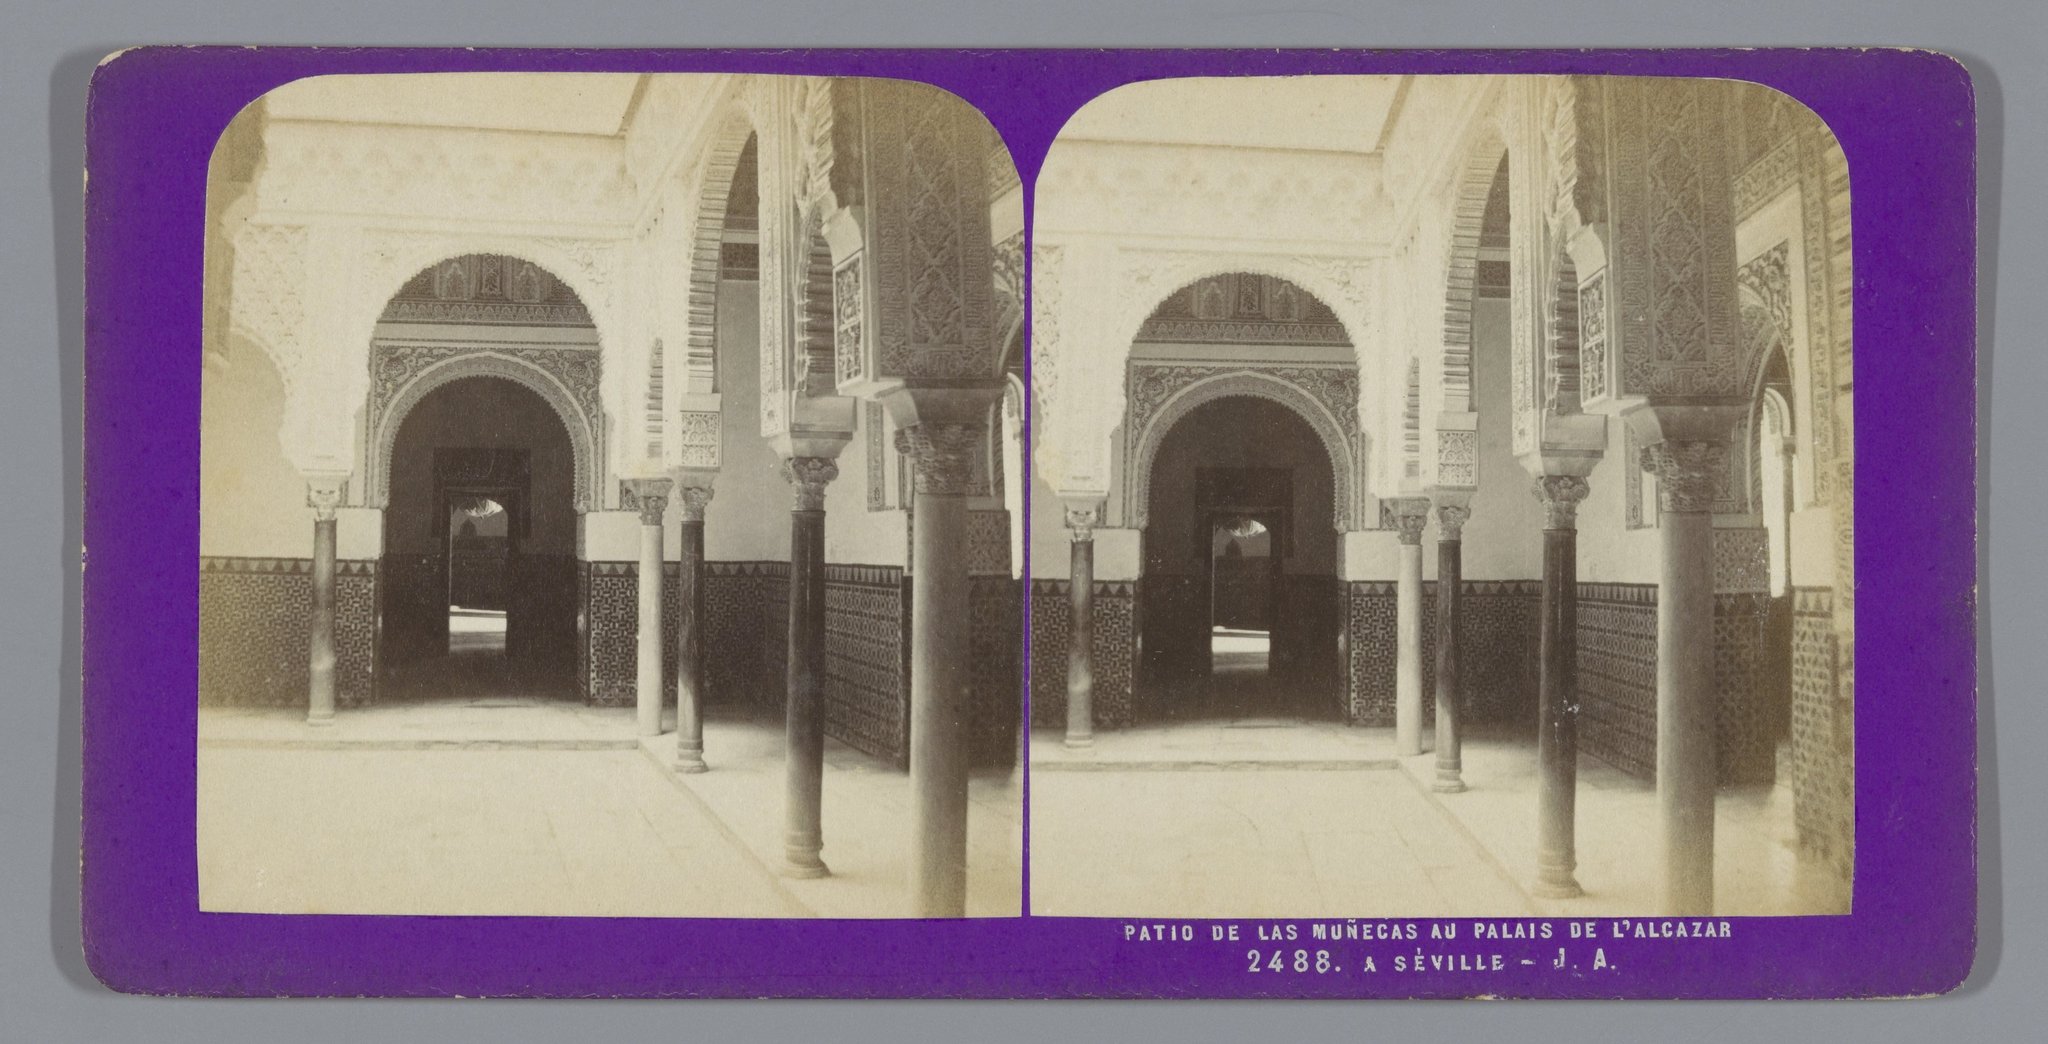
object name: stereograph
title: Patio de Las Muñecas au Palais de l'Alcazar a Séville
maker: jean andrieu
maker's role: fotograaf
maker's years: 1816-1872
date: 1862-1876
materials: cardboard, photographic support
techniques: albumen print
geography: royal palace of seville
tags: arch, archivolt ~ architecture, courtyard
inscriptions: number: ‘2488.’